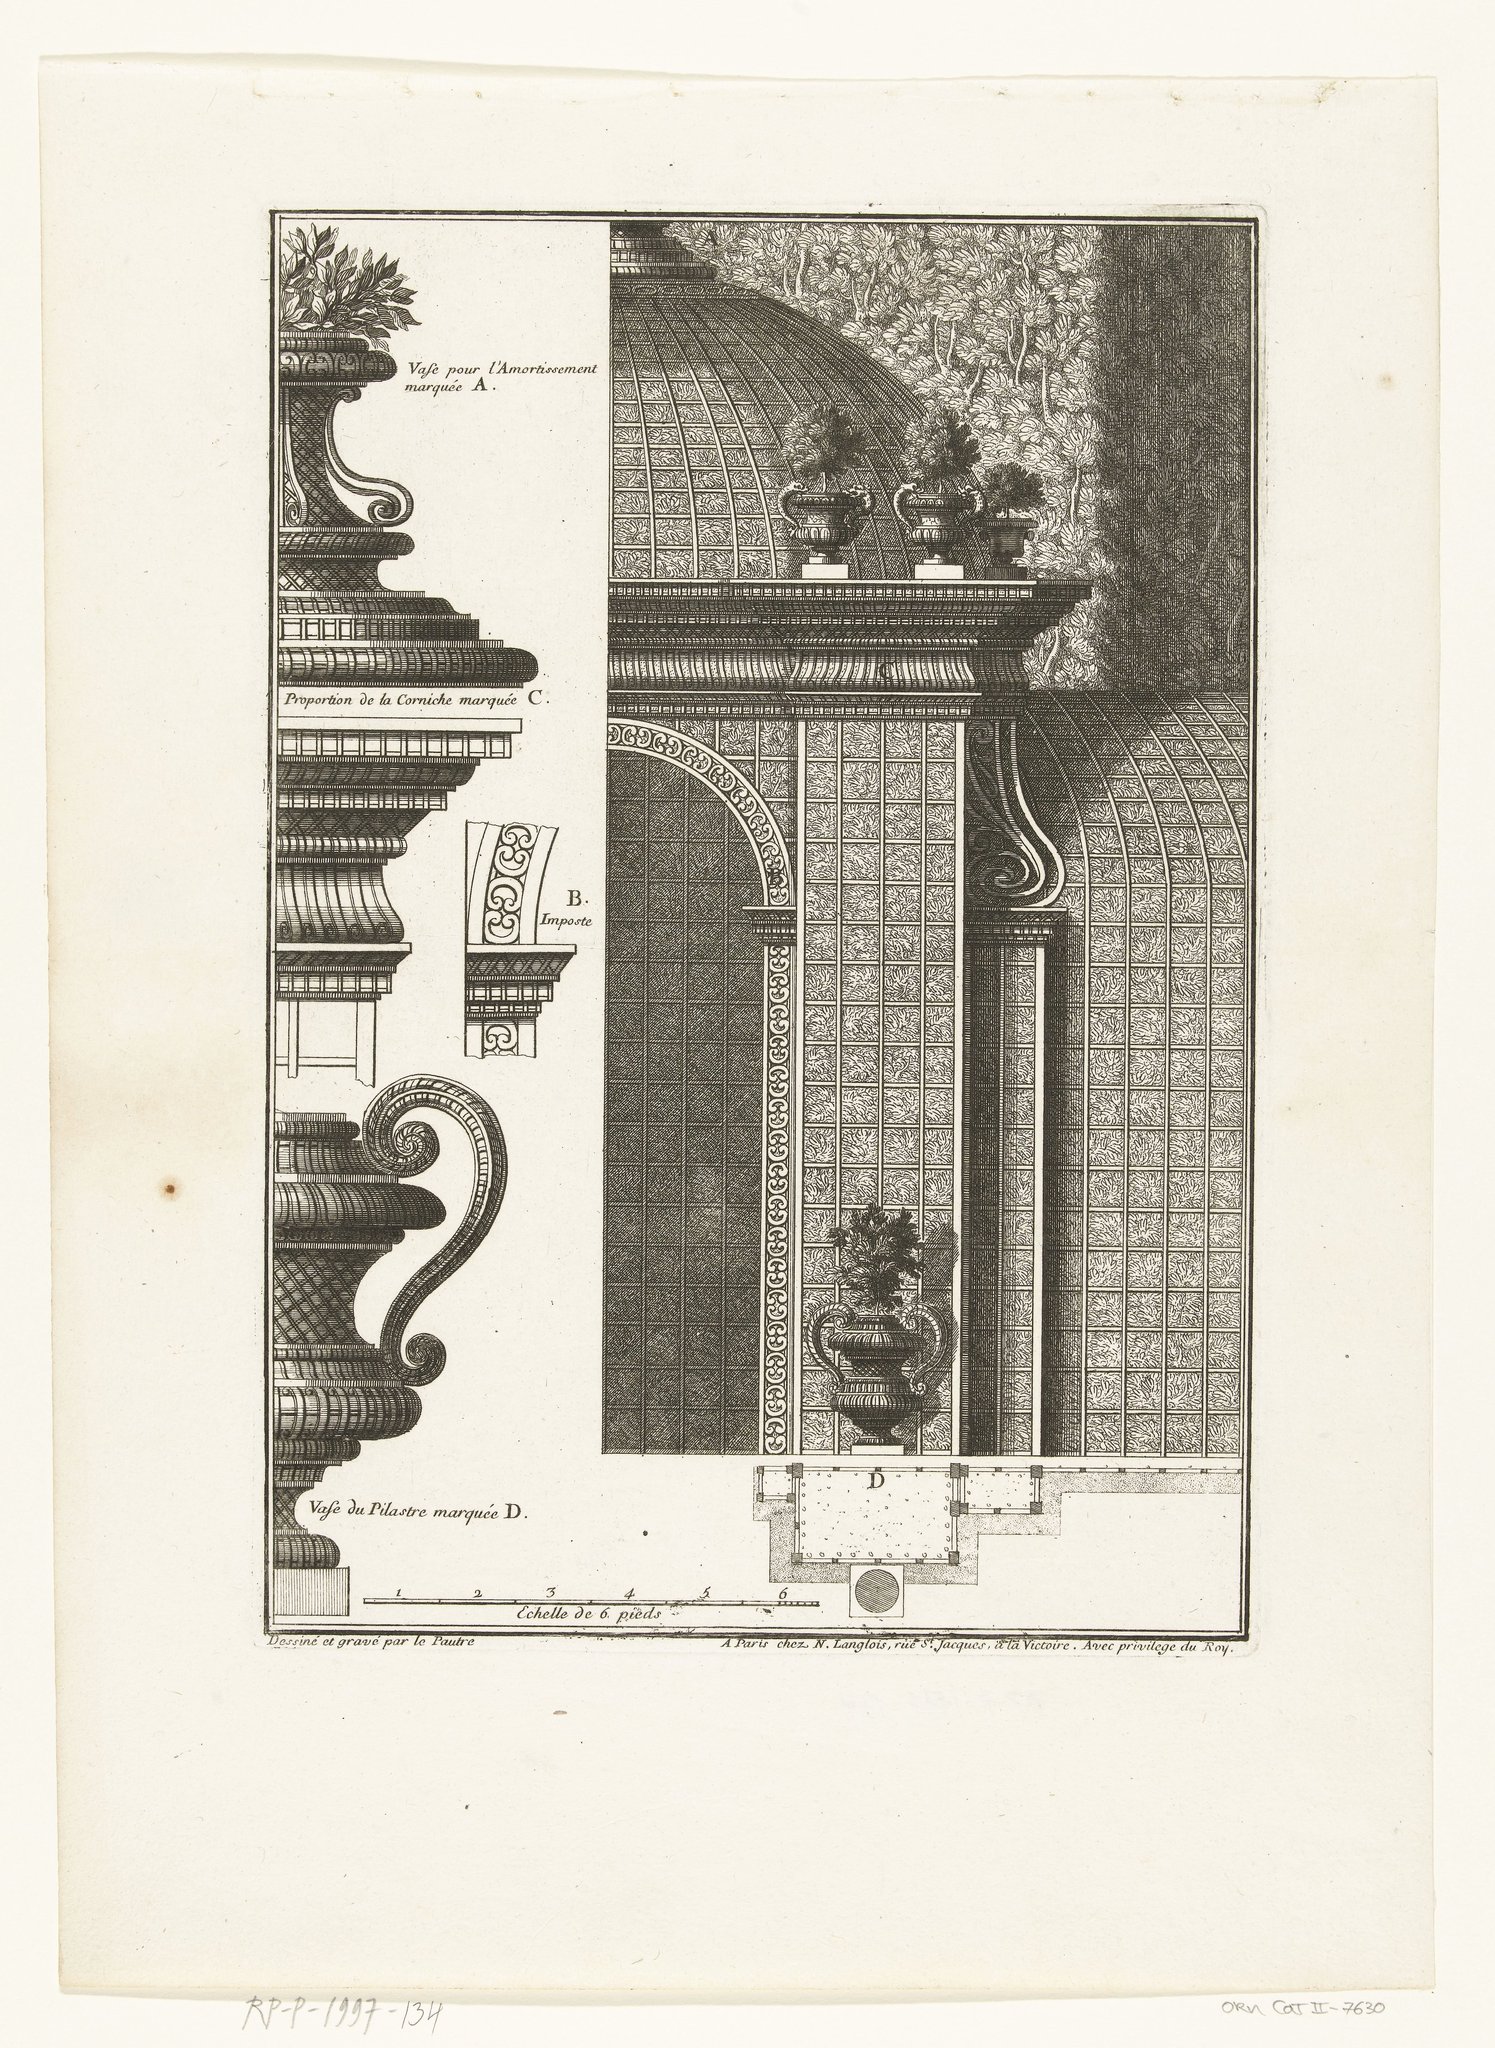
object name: print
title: Latwerkpaviljoens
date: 1670-1703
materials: paper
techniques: etching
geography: france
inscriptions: inscription: ‘Middenonder meetllat met tekst: Echelle de 6 pieds. L.o. bij vaas: Vase du Pilastre marquéD. r.b. bij vaas: Vase pour l'Amortissement marqué a. Onder de vaas: Proportionde la Corniche marqué C. Daaronder: B. Imposte.’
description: Met plan en details van het kroonelement, twee halve vazen, een kroonlijst en een impost. Uit serie van 6 bladen, tweede editie.